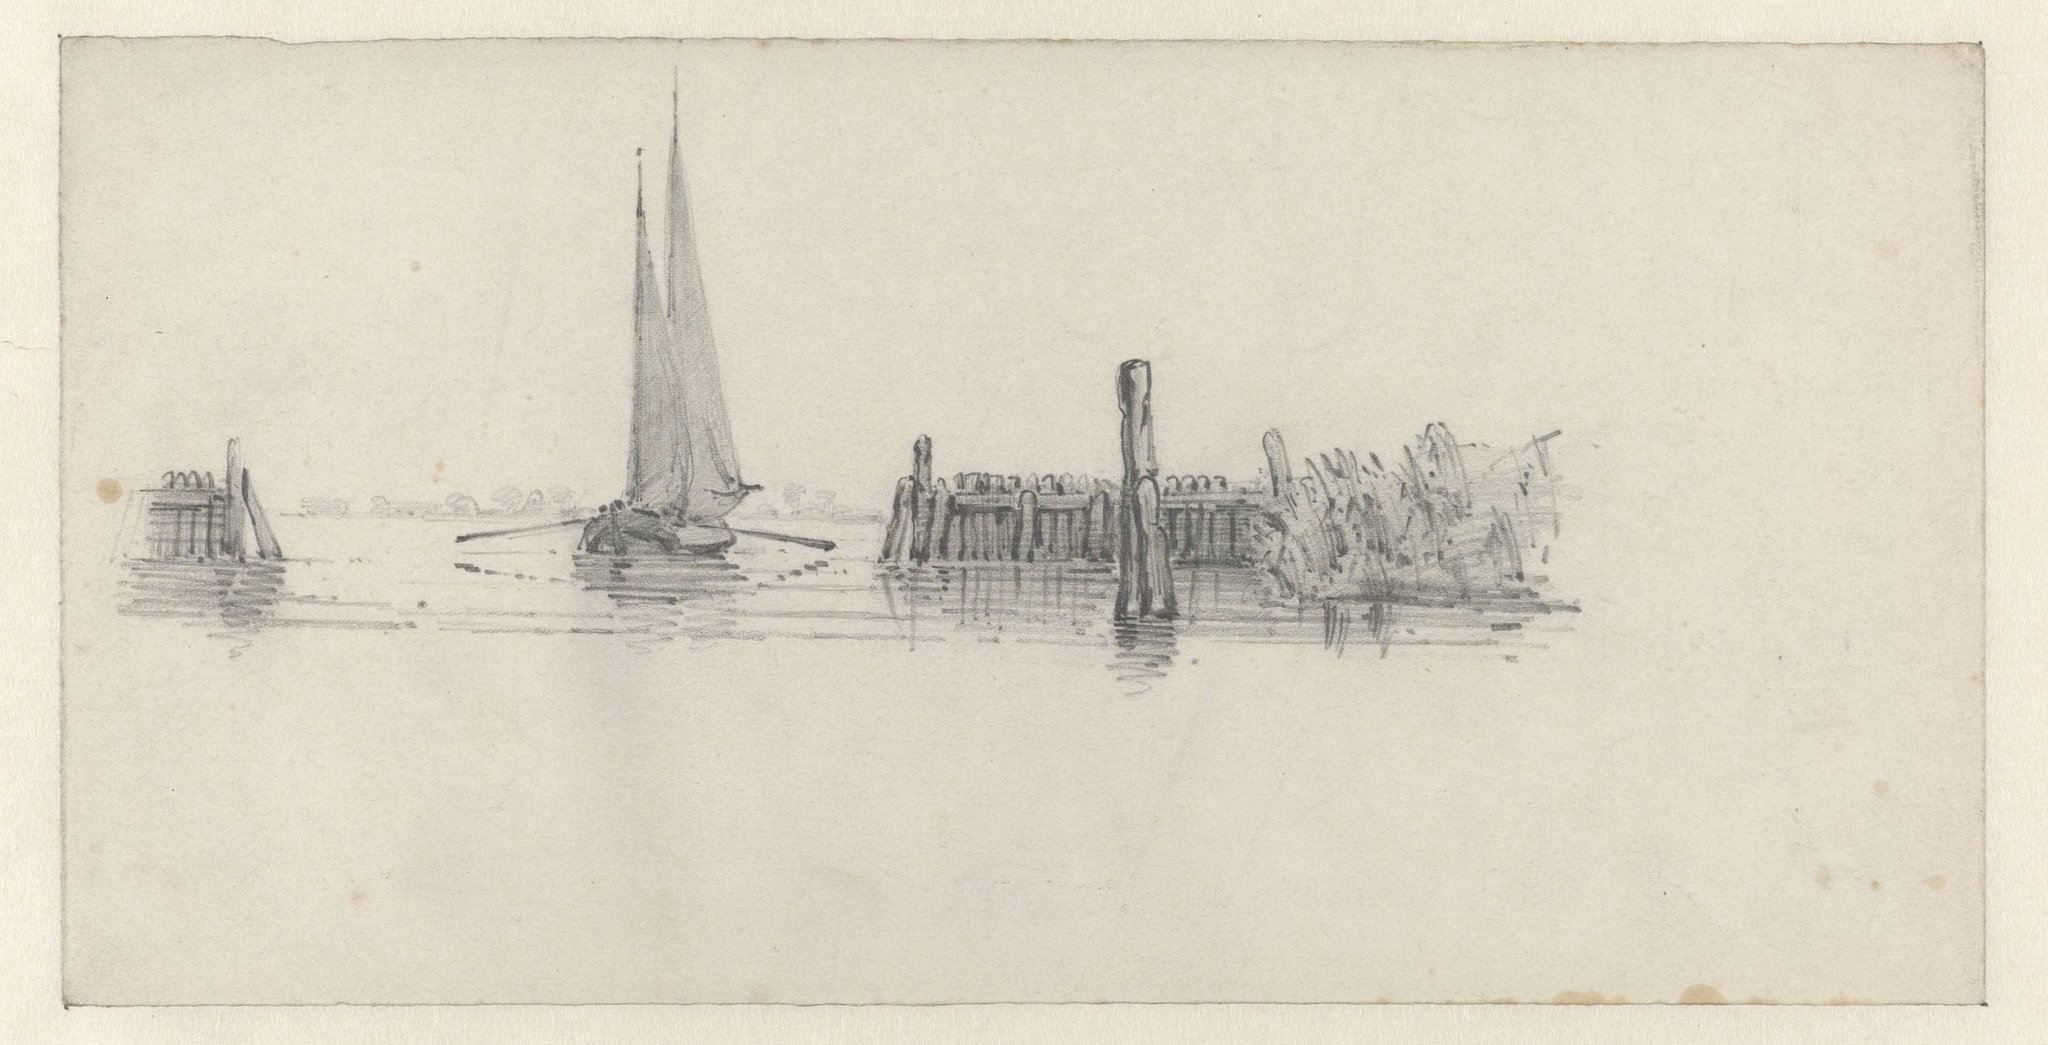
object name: drawing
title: Boot op een plas tussen palissaden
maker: johan conrad greive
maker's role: draughtsman, painter, print maker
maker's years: 1837-1891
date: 1847-1891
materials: paper, pencil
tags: sailing-ship, sailing-boat, river